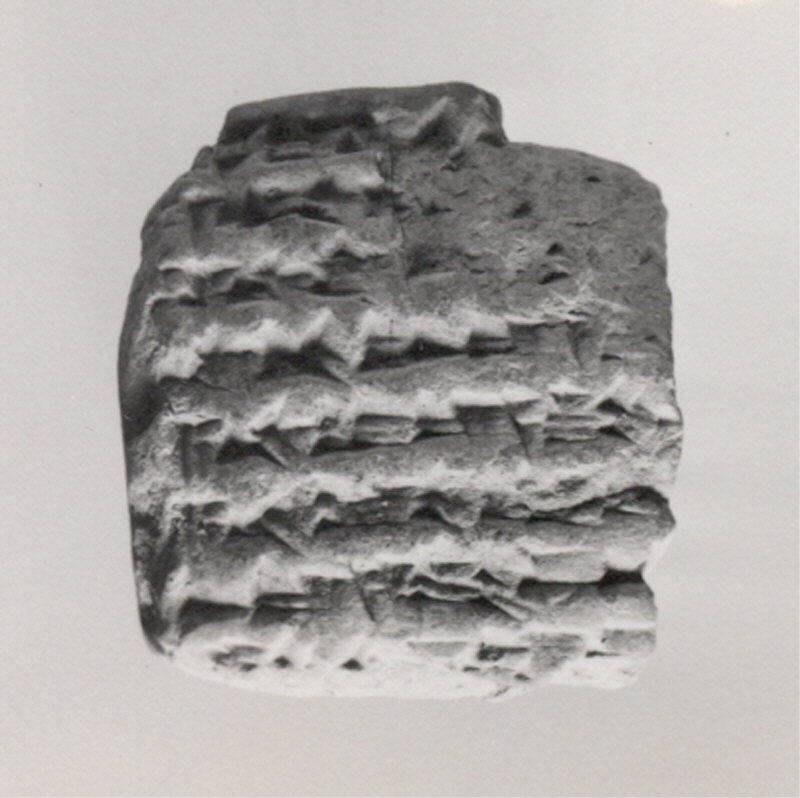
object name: cuneiform tablet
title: Cuneiform tablet: account of barley, Ebabbar archive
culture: babylonian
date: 700-501 BCE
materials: clay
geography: mesopotamia